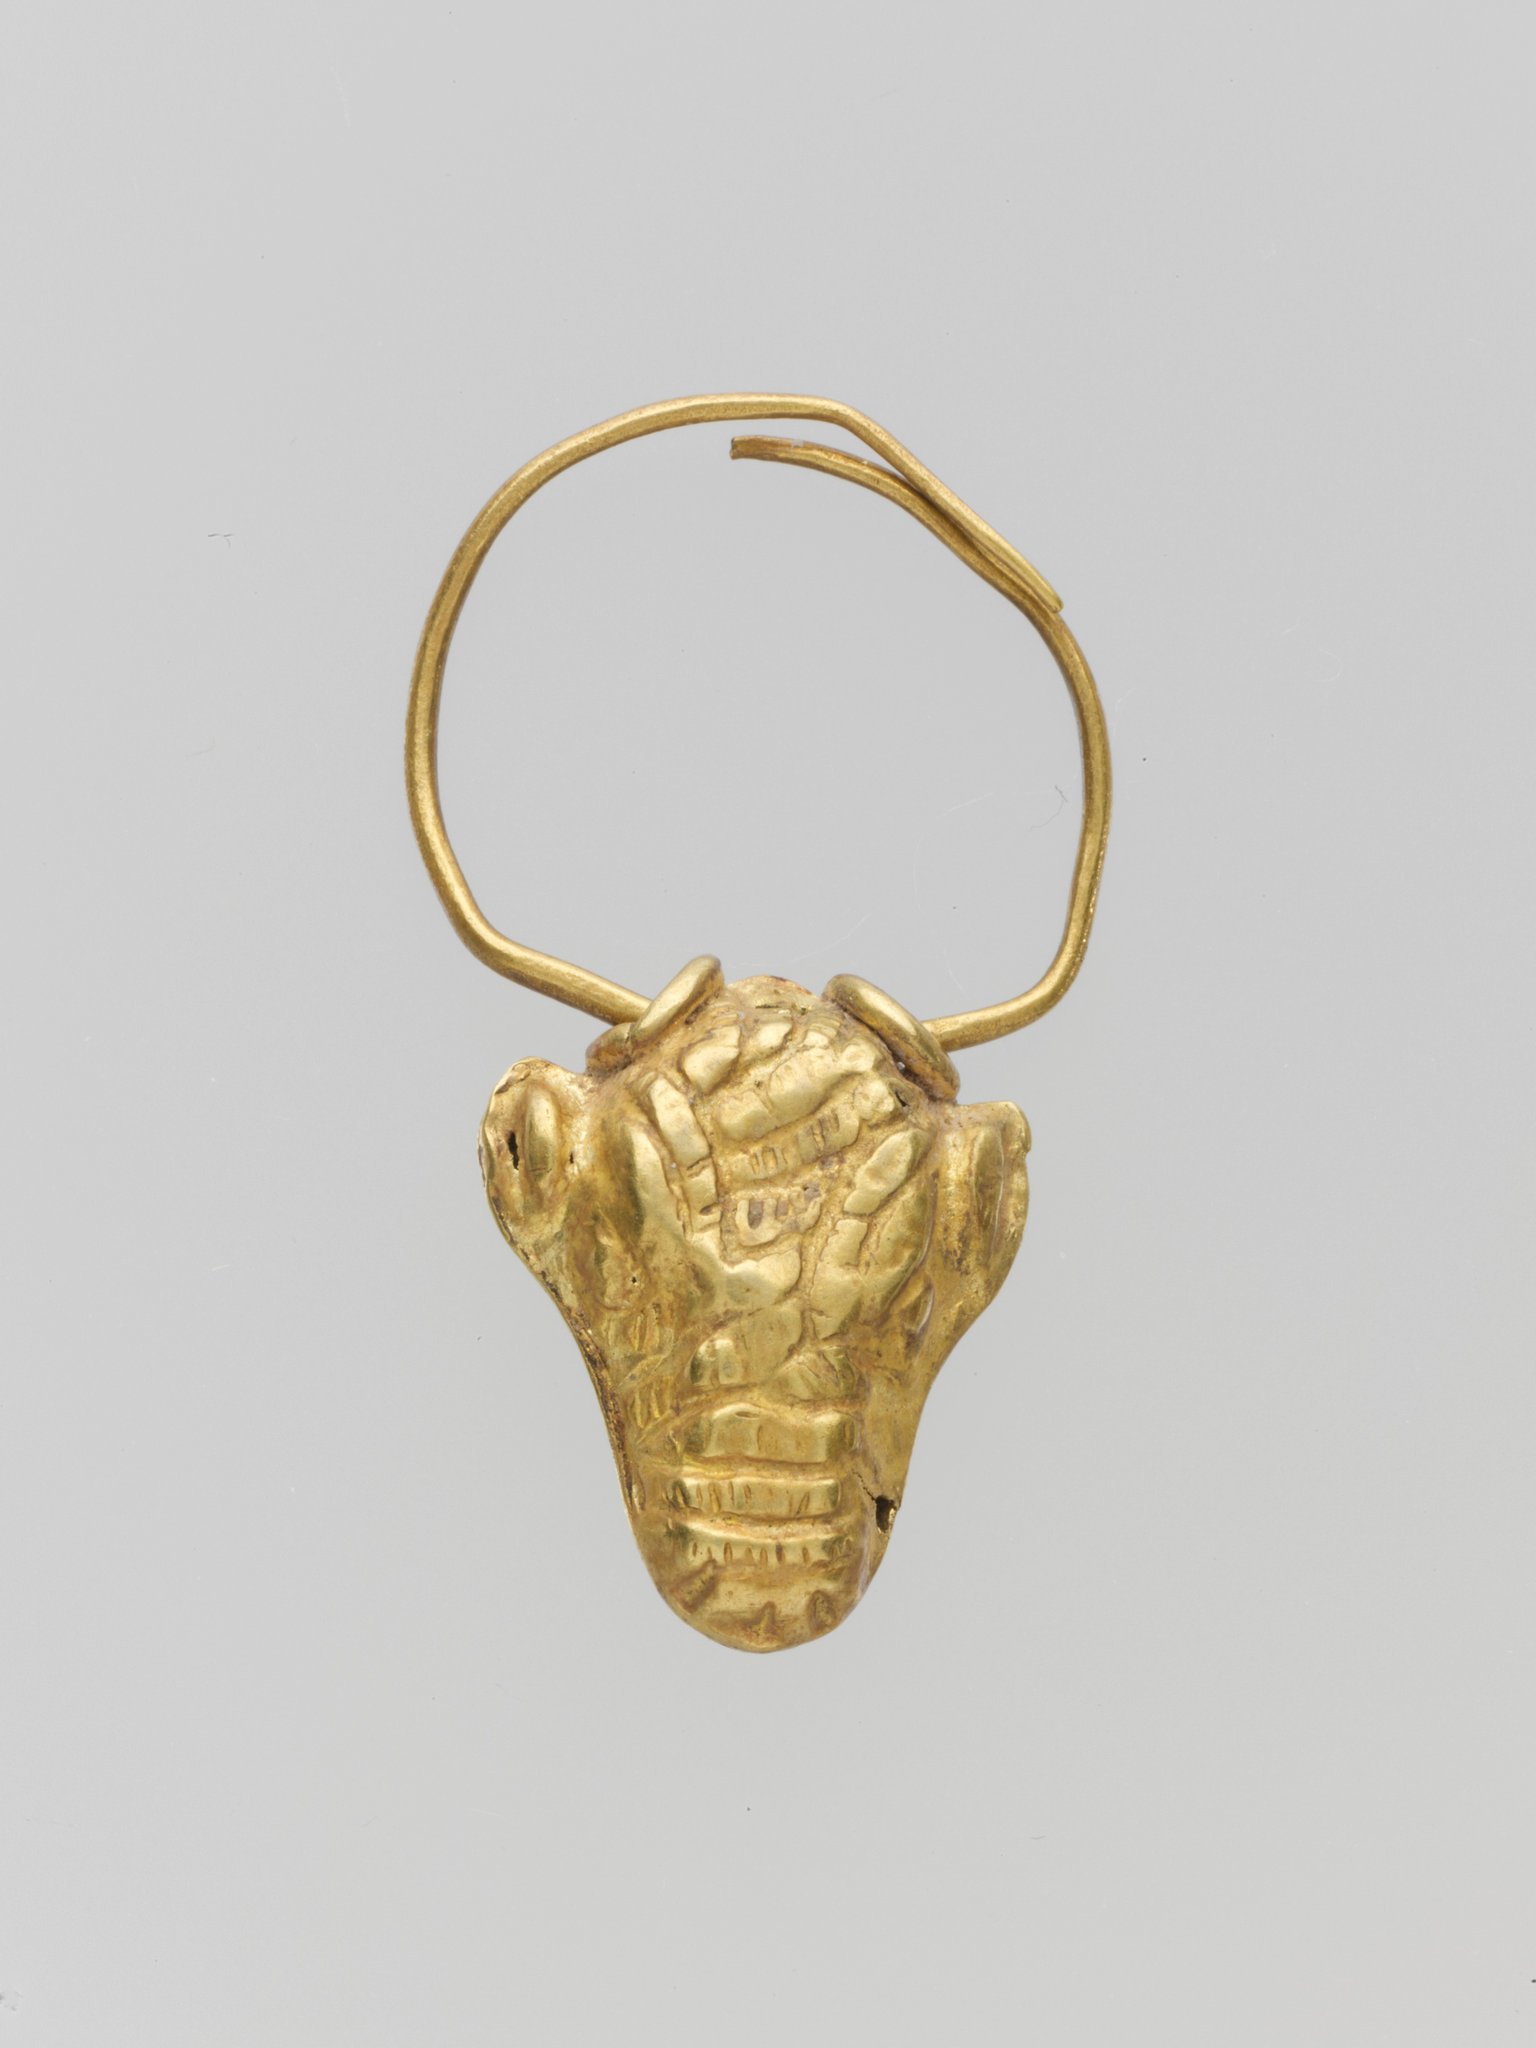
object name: earring with head of bull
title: Gold pendant in the form of a bull's head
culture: cypriot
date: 1400-1050 BCE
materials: gold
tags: bulls